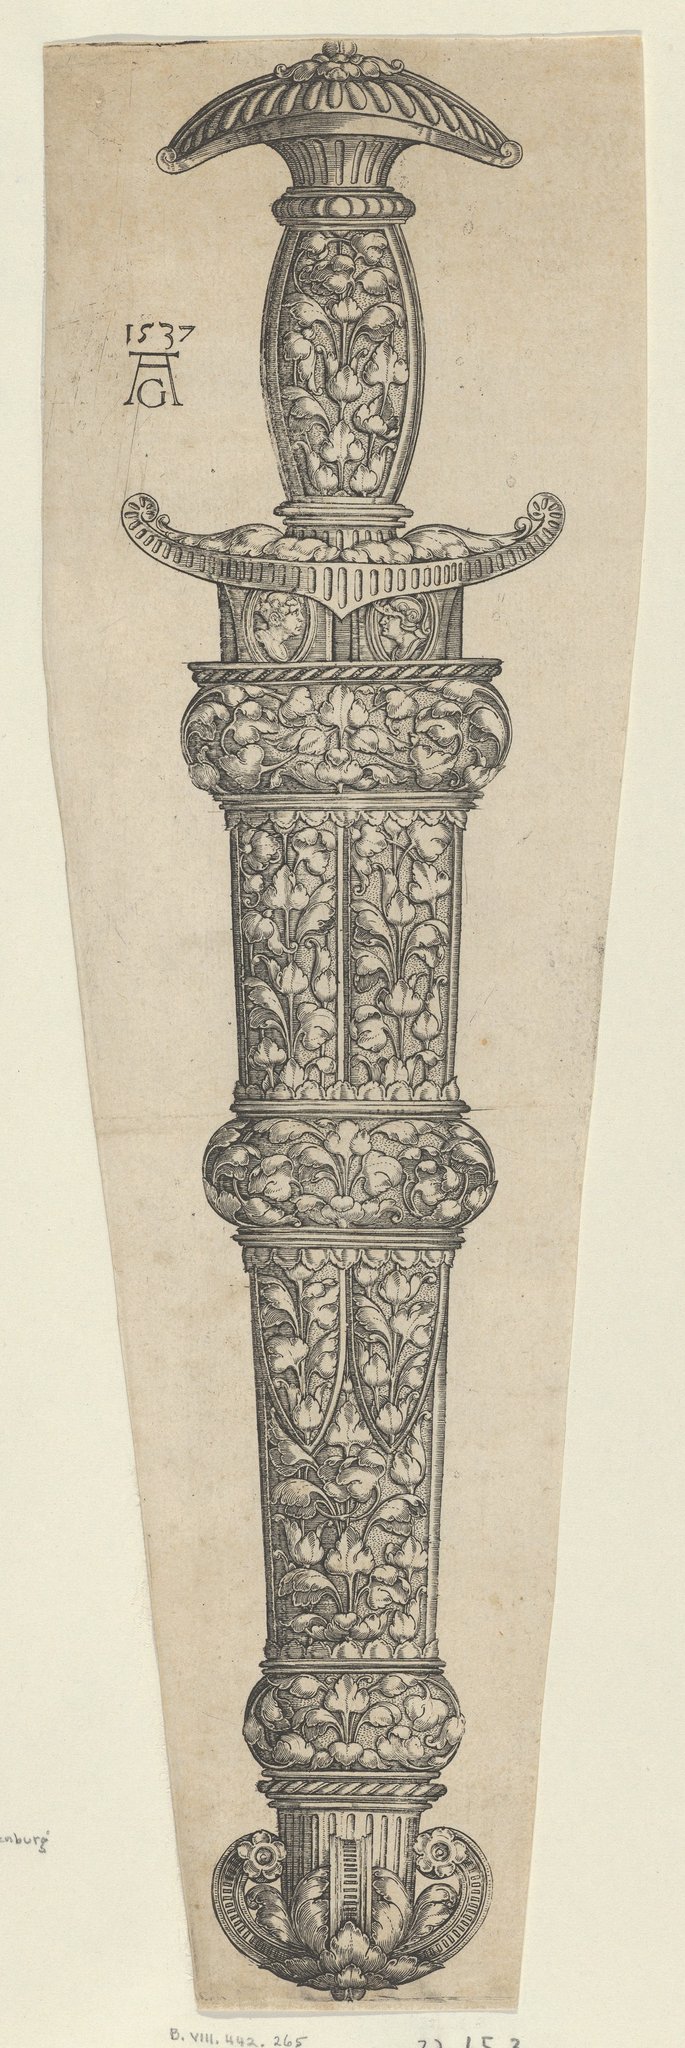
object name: print ornament architecture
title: Dagger Sheath Decorated with Tendrils and Two Profiles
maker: heinrich aldegrever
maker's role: artist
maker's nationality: german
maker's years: 1502-1561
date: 1537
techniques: engraving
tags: daggers